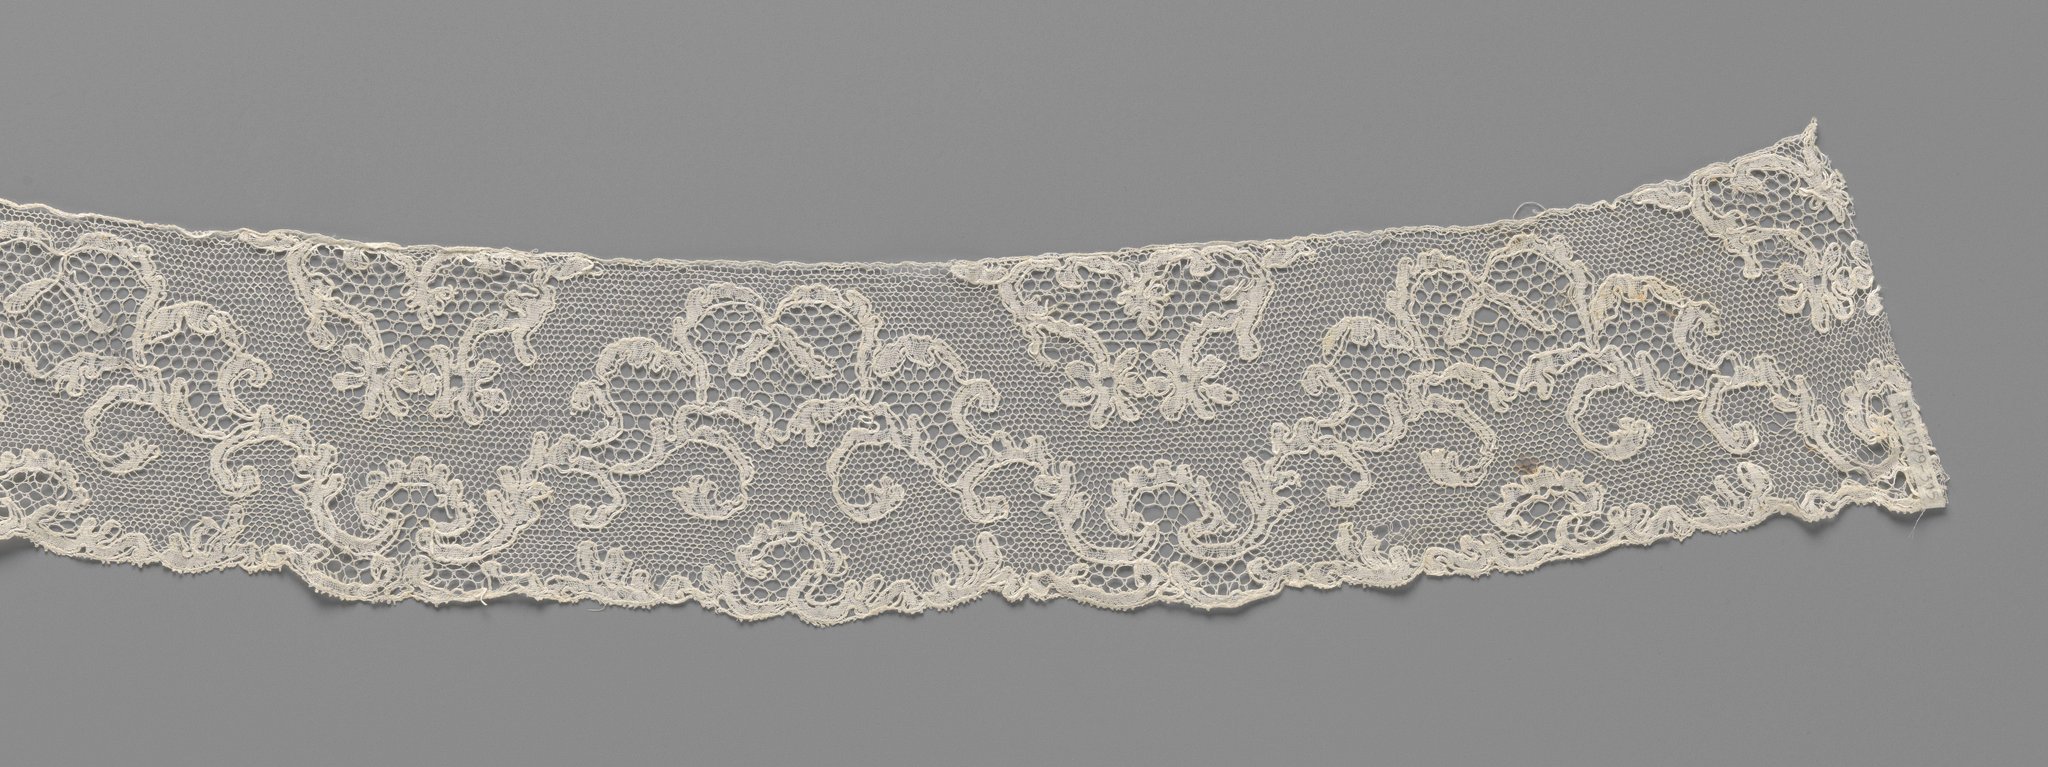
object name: strip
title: Strook kloskant met hart-vormige cartouches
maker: Anonymous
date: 1850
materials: linen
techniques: lace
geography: tonderen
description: Strook naturelkleurige kloskant: Rijselse kant. Het zich herhalende patroon bestaat uit min of meer hart-vormige cartouches die langs de bovenzijde van de strook liggen en worden gevormd door gespiegelde vraagtekens met onderaan een zeslobbige bloem. De cartouches hangen in een geschulpt halfcirkelvormig veld. Deze velden worden gevormd door bogen van aaneengeschakelde cartouches en bladvoluten. De motieven zijn gemaakt in linnenslag, met dikkere en glimmende contourdraden. De motieven zijn met elkaar verbonden door een fijne traliegrond, een tulegrond. In de cartouches zijn siergronden toegepast waaronder een rozengrond. De bovenzijde is recht afgewerkt. De zeer flauw geschulpte onderzijde is afgewerkt met picots.